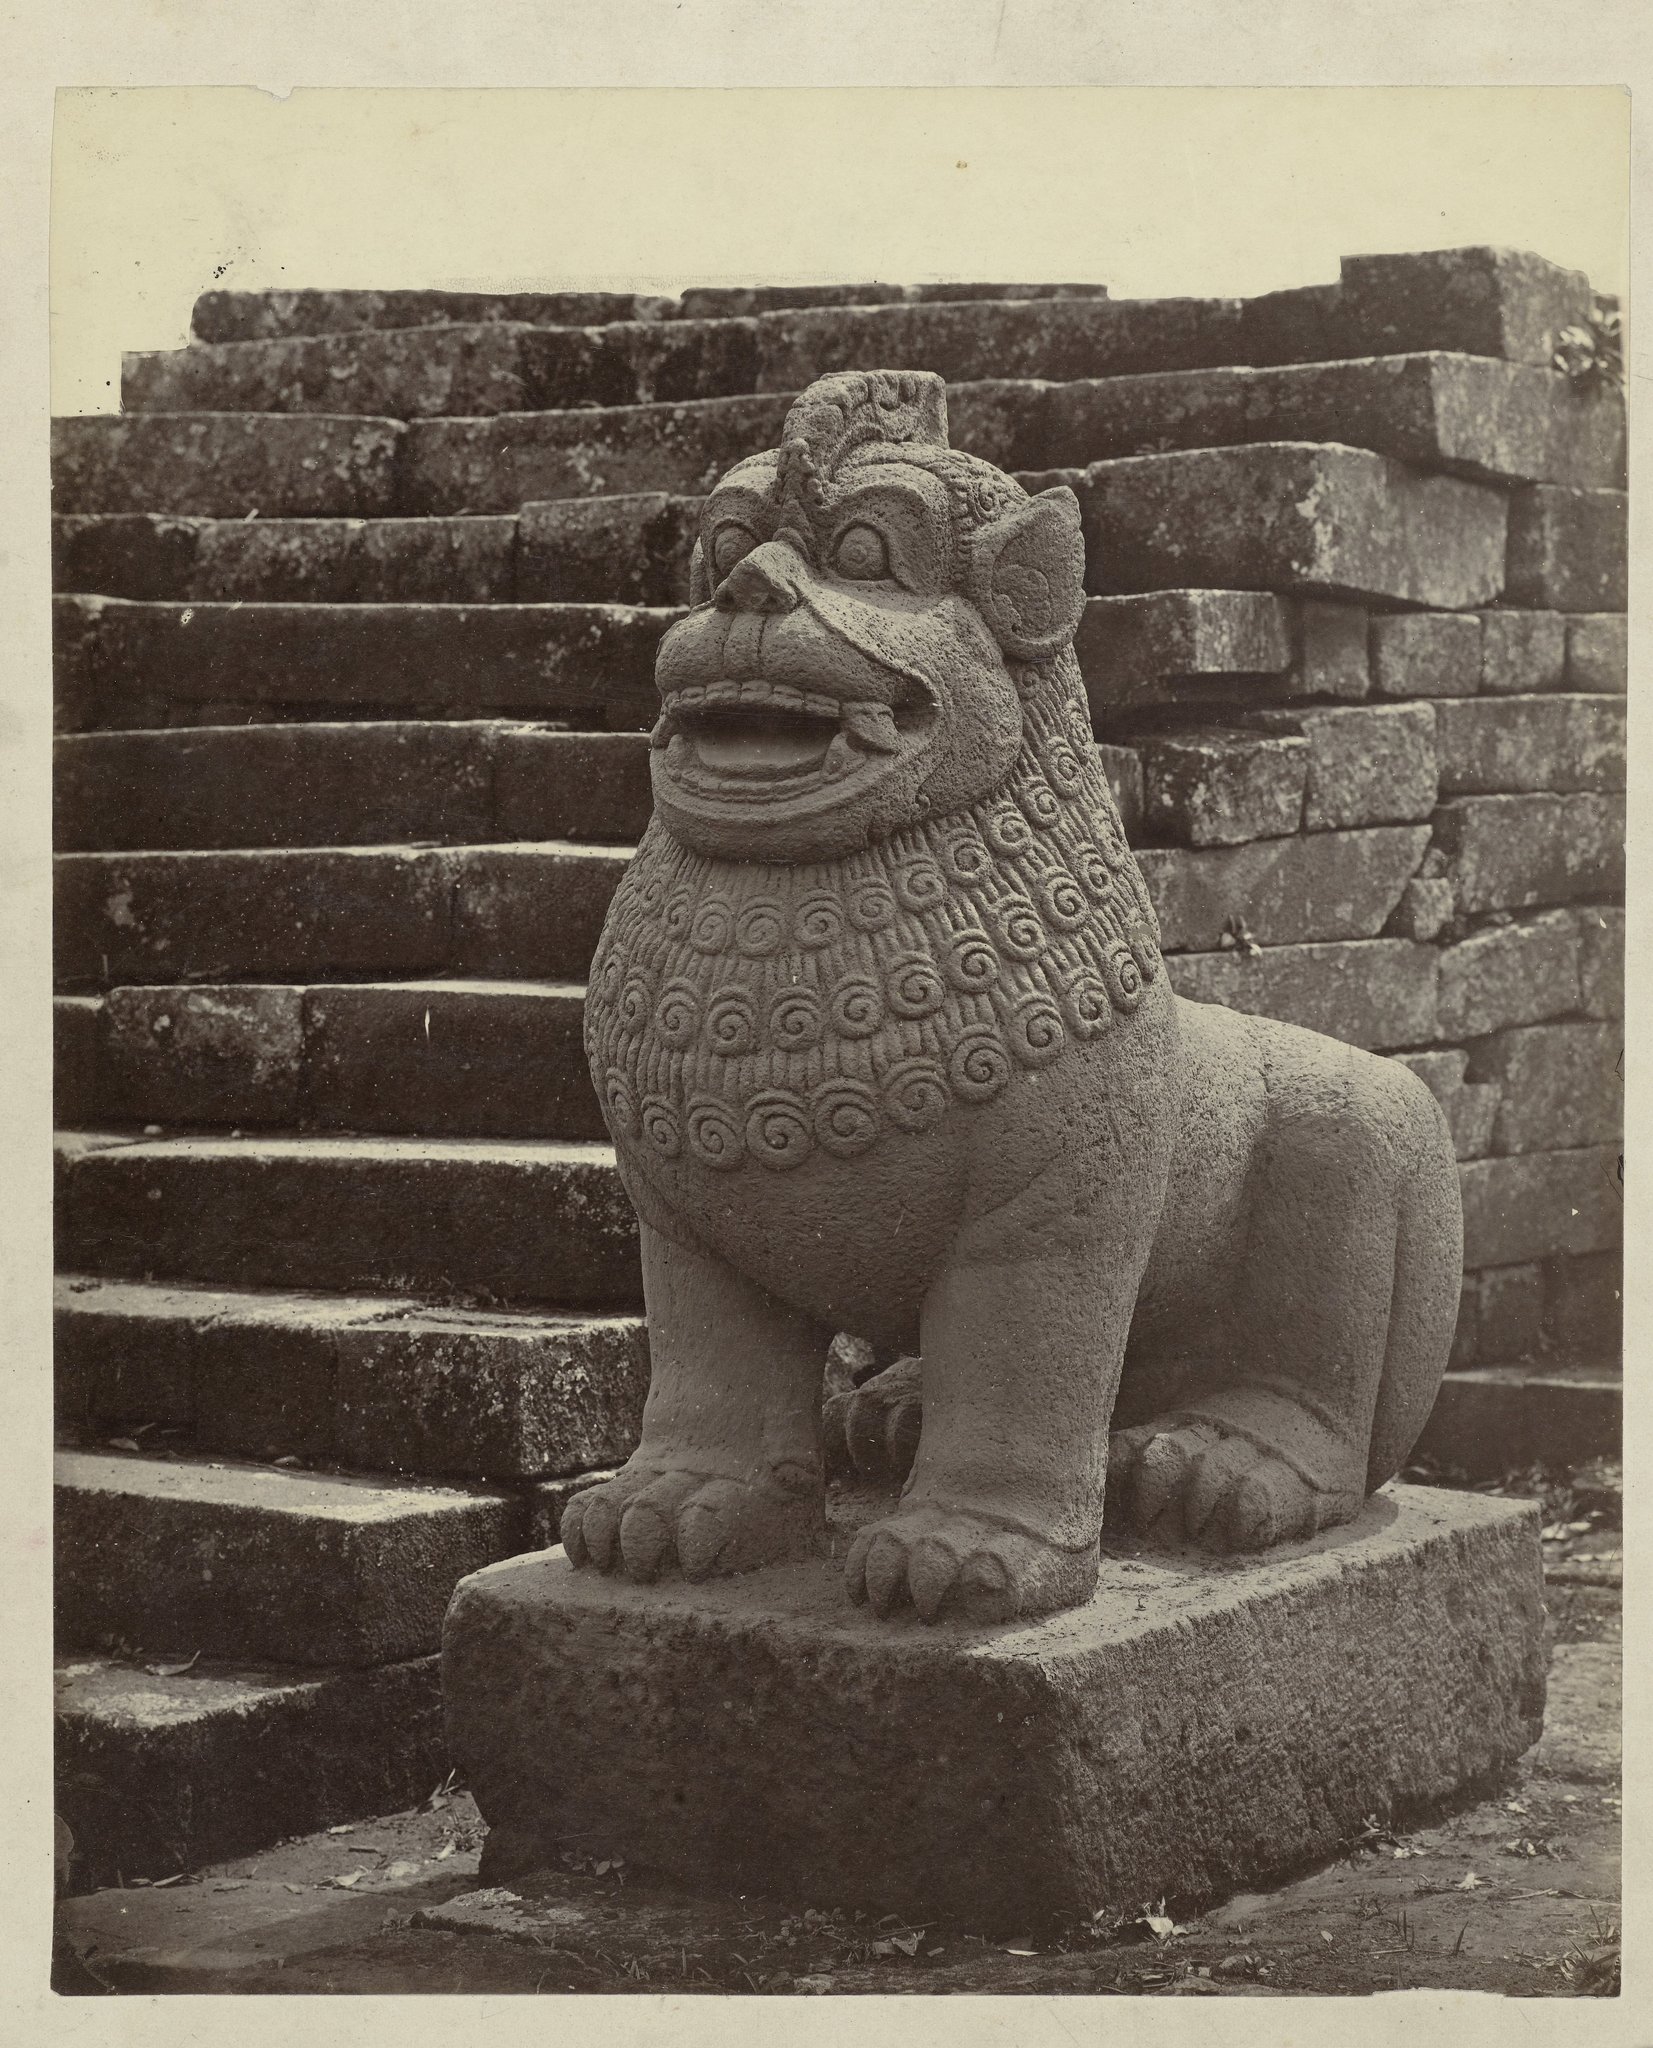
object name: photograph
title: Singa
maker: isidore kinsbergen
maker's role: fotograaf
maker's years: 1821-1905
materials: cardboard, paper, photographic support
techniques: albumen print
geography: java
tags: borobudur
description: Lion figure at one of the stairways.Borobudur village, Magelang district, Central Java province, 778-824 AD.